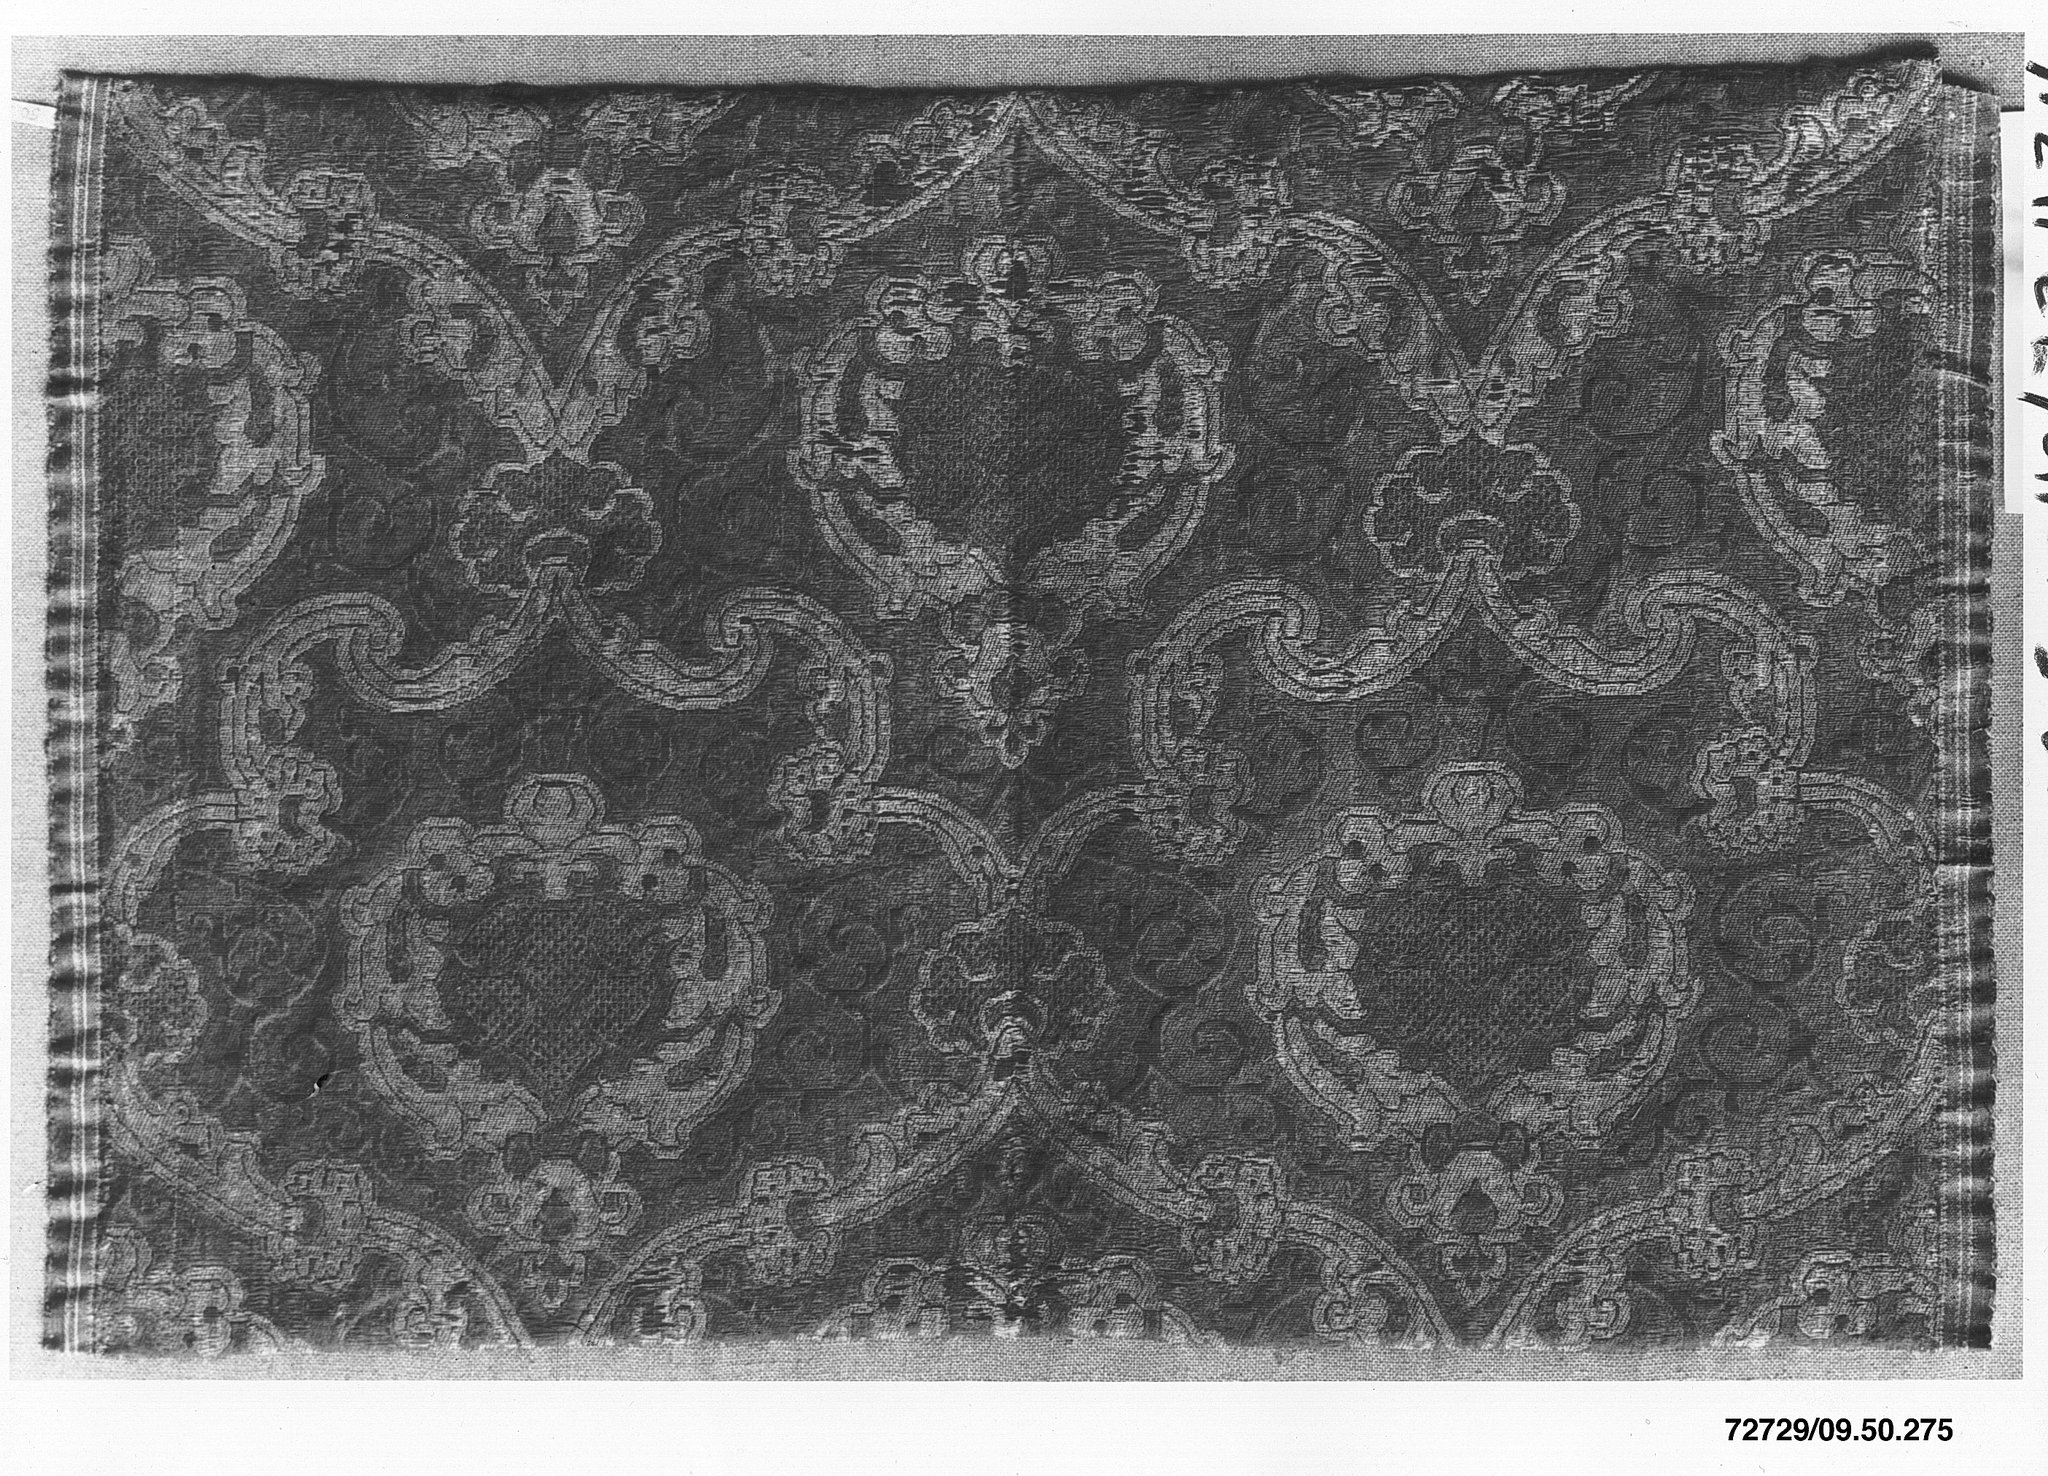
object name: piece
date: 1501-1600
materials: linen, metal thread, silk